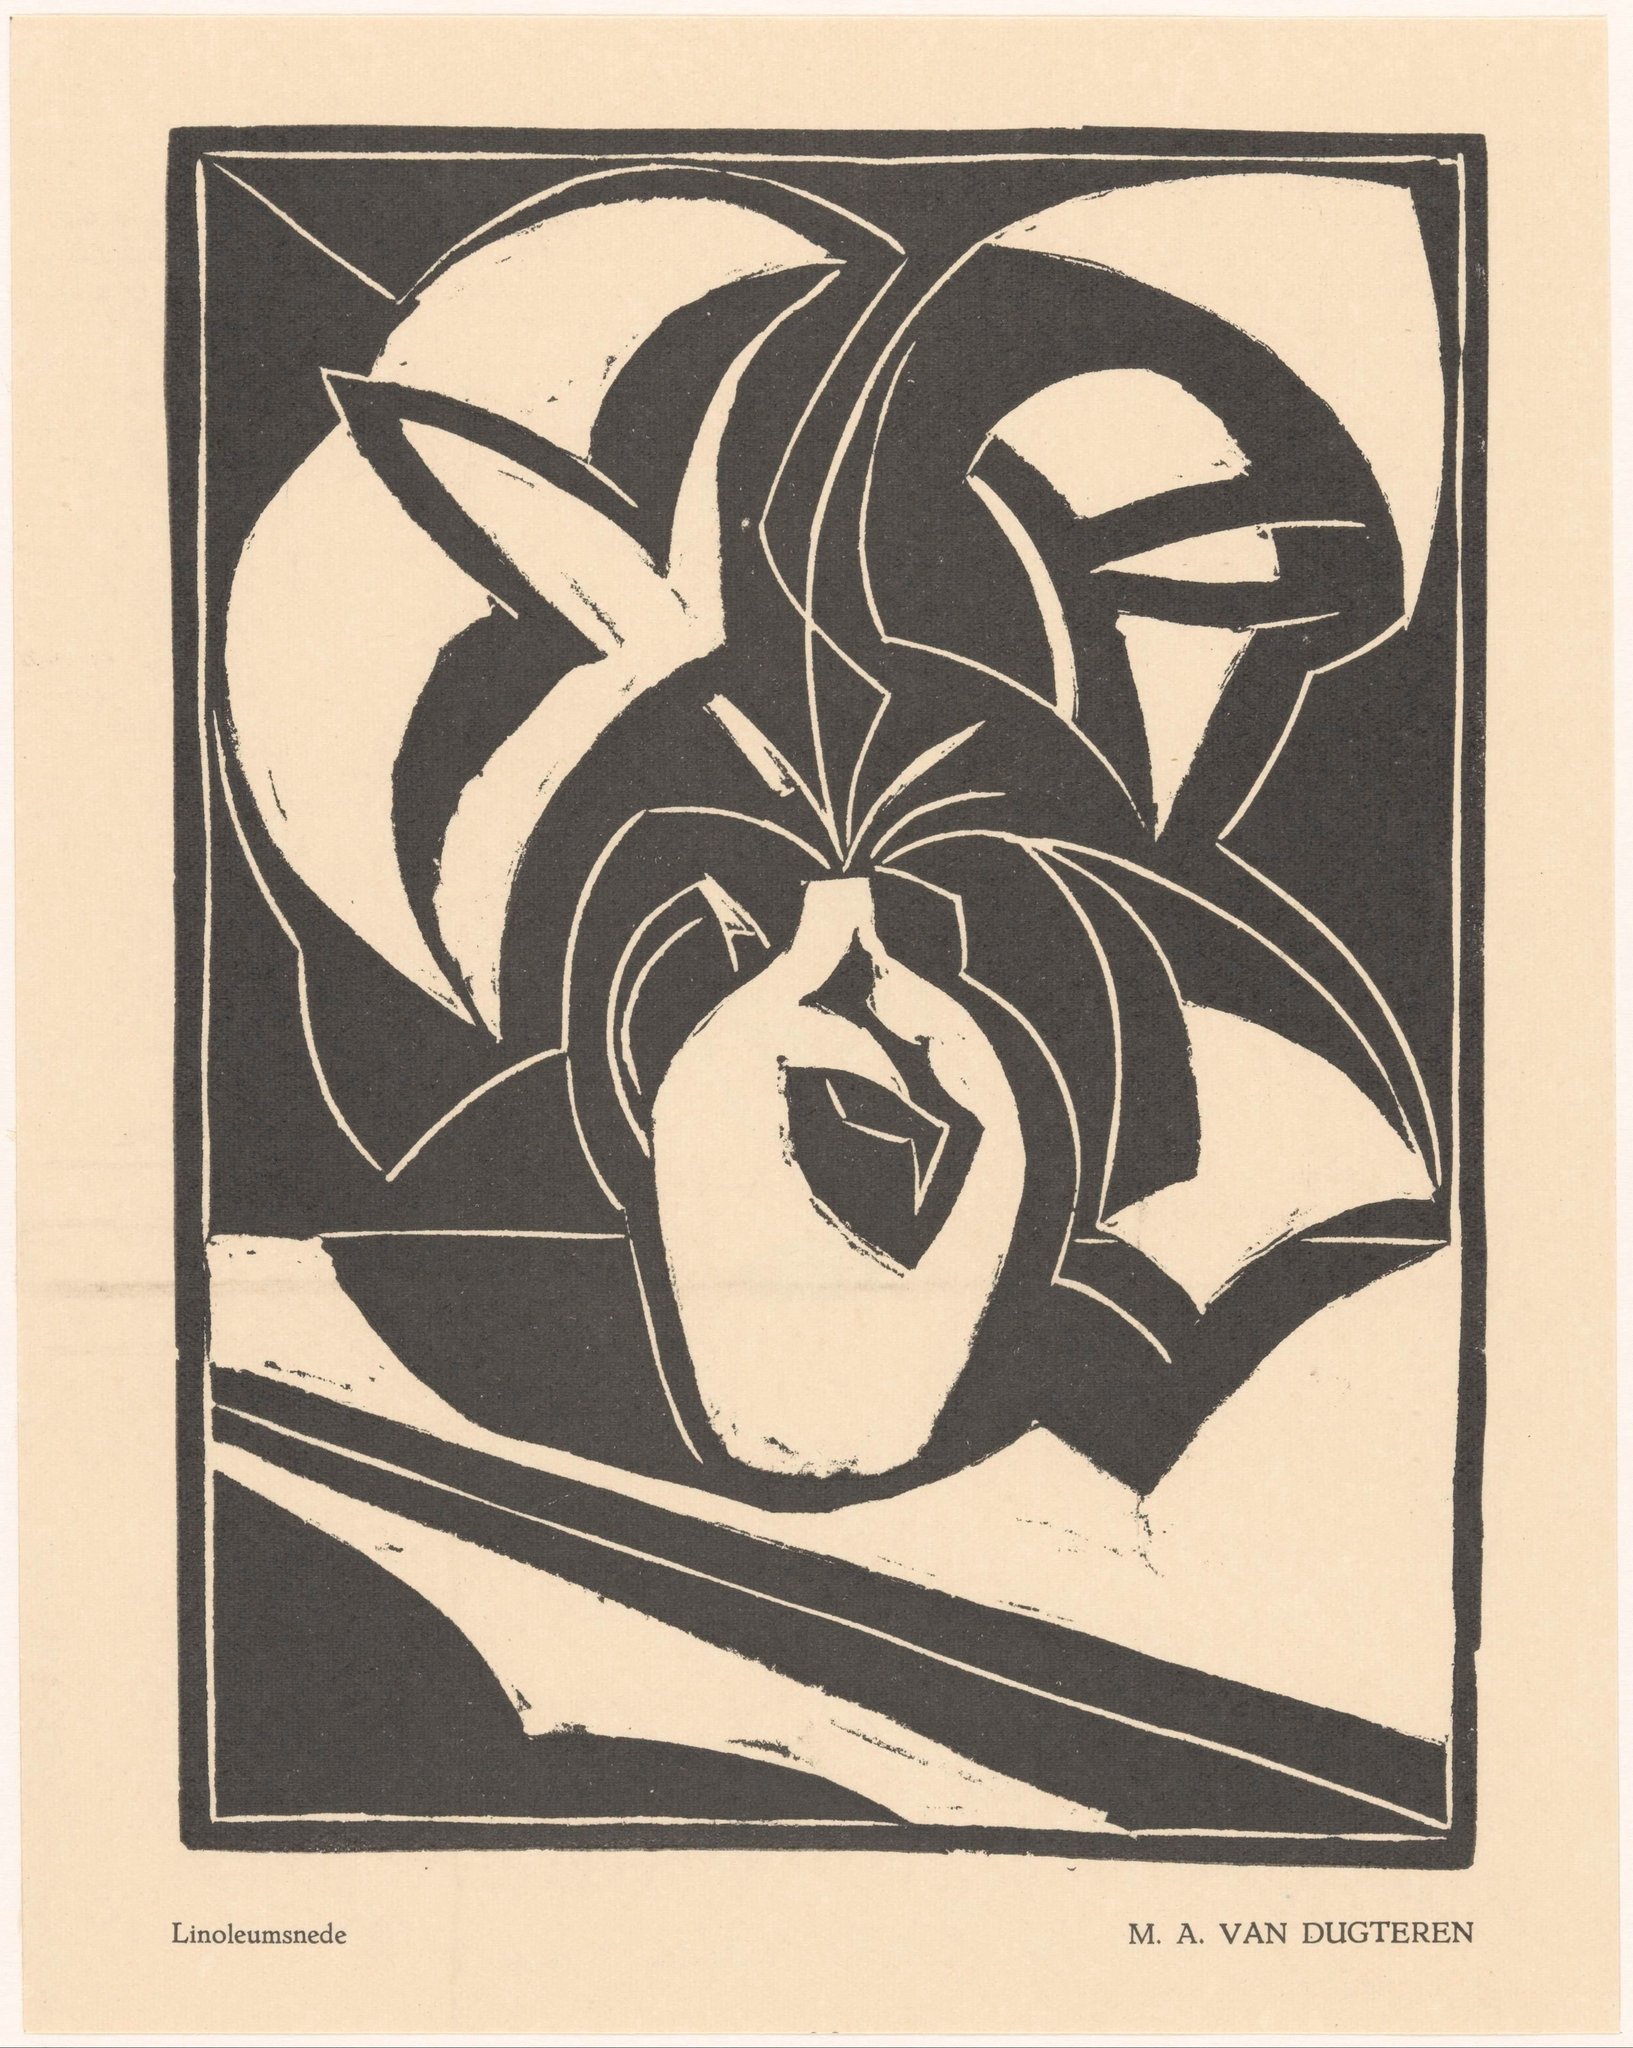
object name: print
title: Bloemen in een kruik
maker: m.a. van dugteren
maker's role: print maker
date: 1925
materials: paper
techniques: linocut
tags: flowers, container of ceramics: jar, jug, pot, vase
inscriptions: collector's mark: Lugt 2228, collector's mark: Lugt 2760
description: Prent gebruikt voor 'De Fakkel', het tijdschrift van de Academie van Beeldende Kunsten en Technische Wetenschappen in Rotterdam.